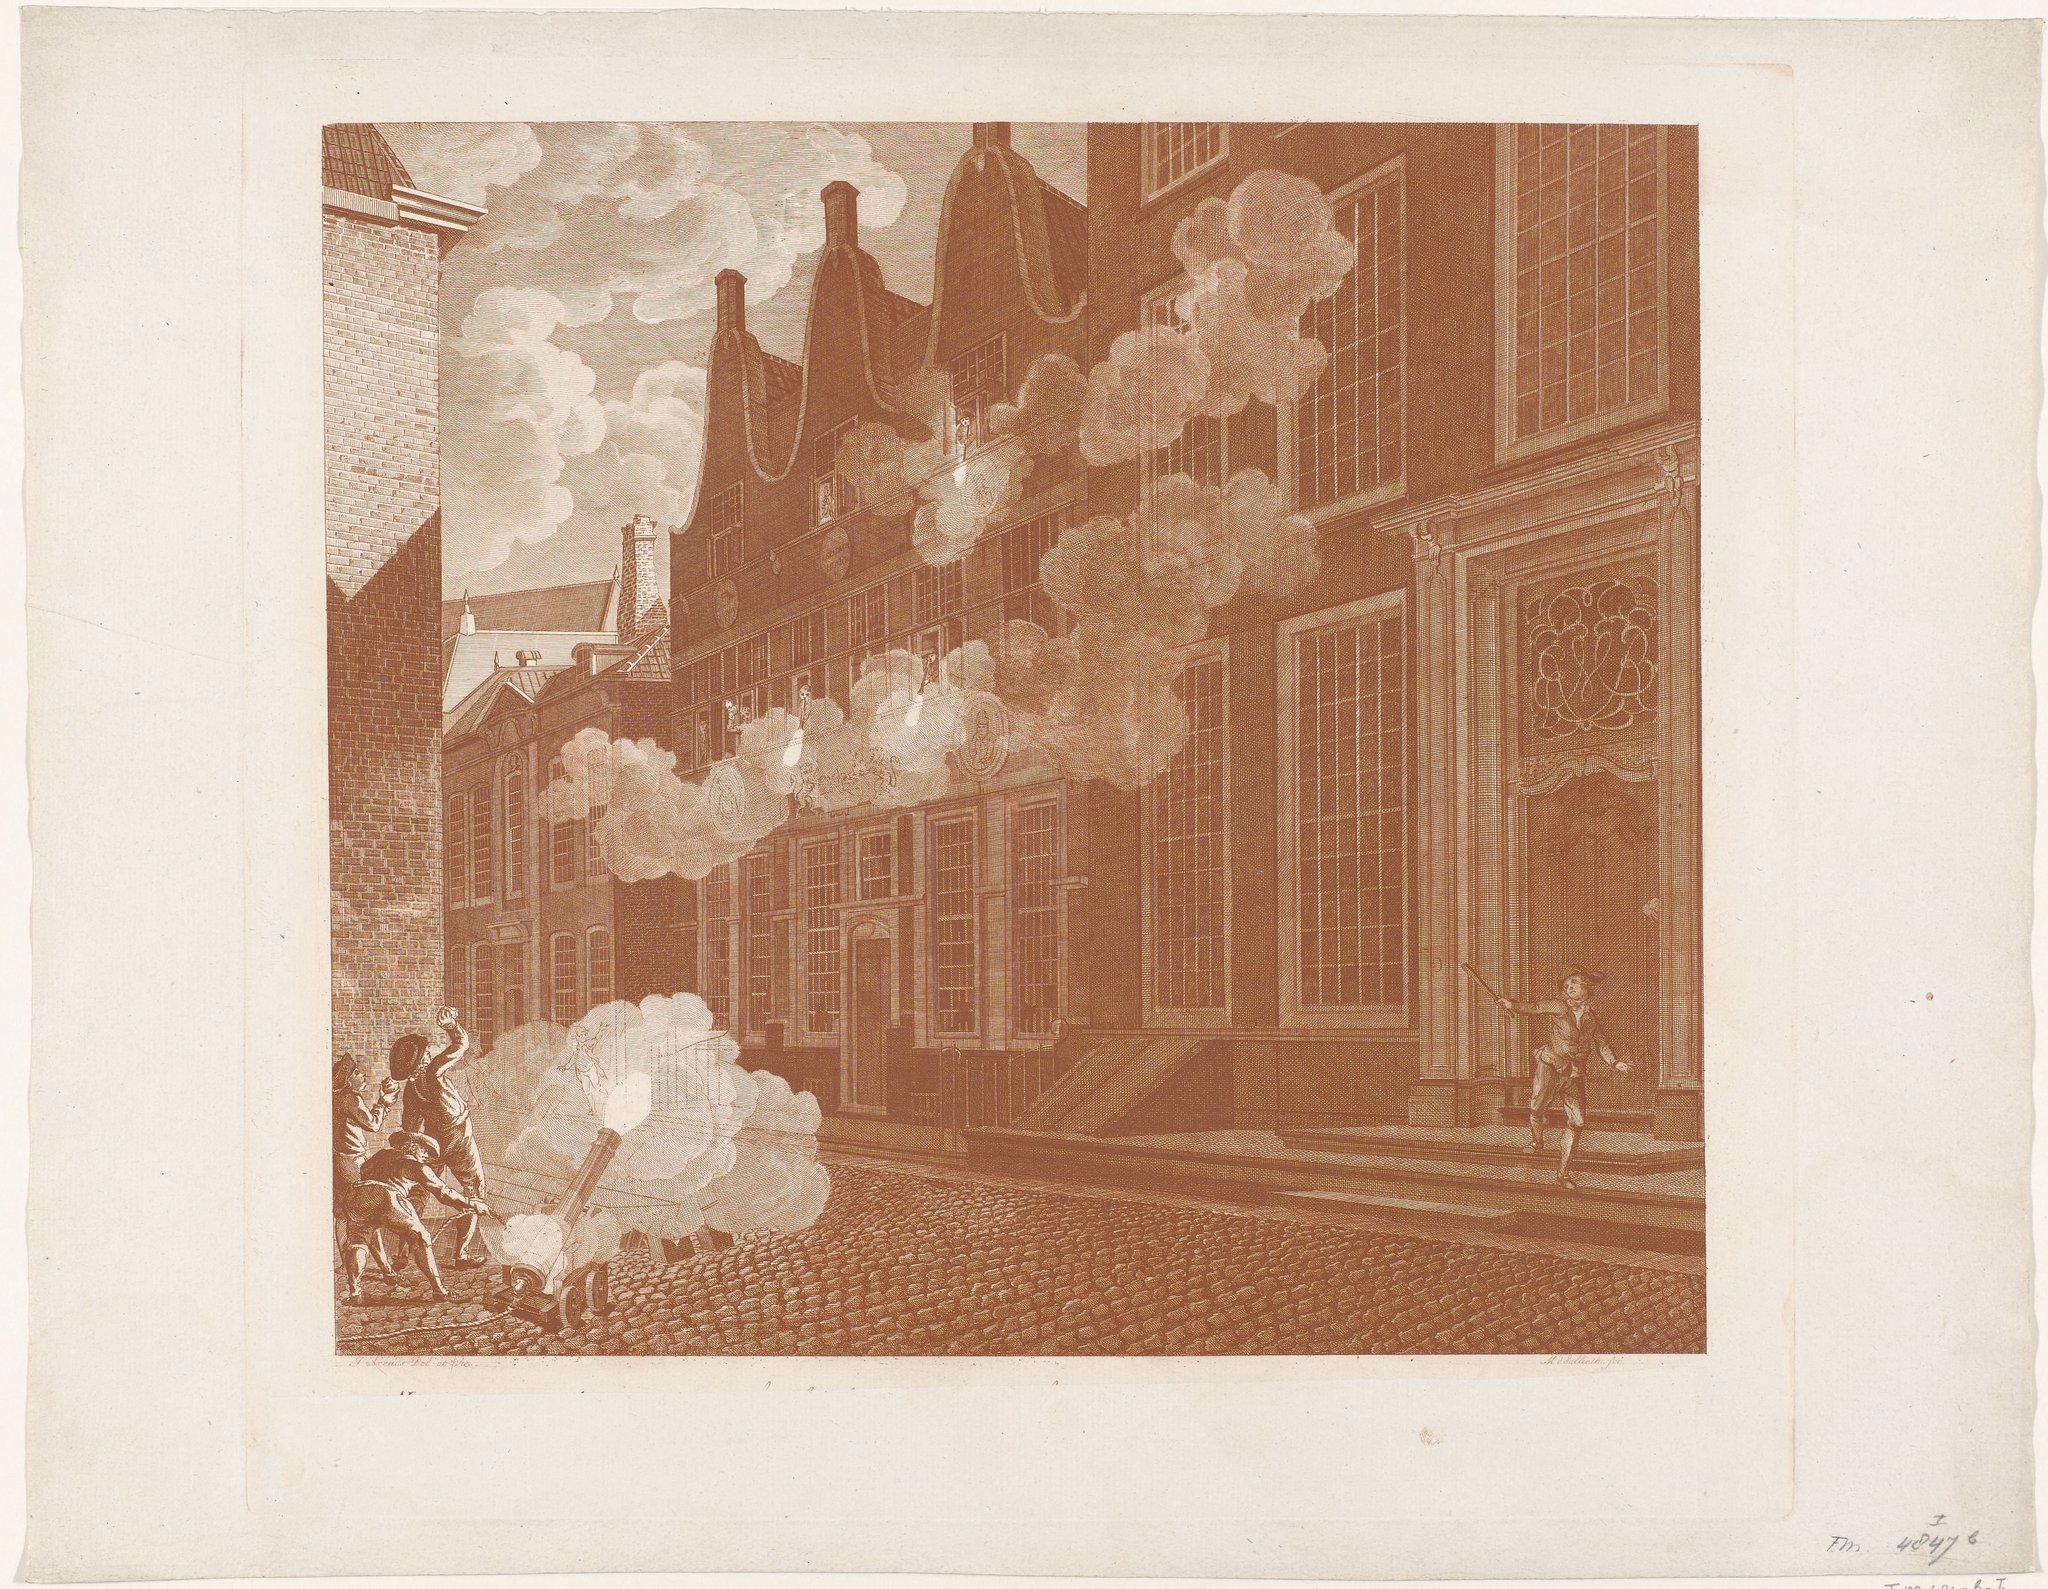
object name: print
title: Beschieting van het huis van Lucas van Steveninck, 1787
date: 1787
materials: paper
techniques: engraving, etching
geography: rotterdam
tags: amsterdam, street-fights, riots, patriots (1780-1795)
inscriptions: collector's mark: Lugt 2228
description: Oranjegezinden beschieten met een klein kanon het Huis Leeuwenburg te Middelburg van de patriotse arts Lucas van Steveninck, in de nacht van 30 juni op 1 juli 1787. De bewoners schieten vanuit de vensters van het huis met geweren terug.